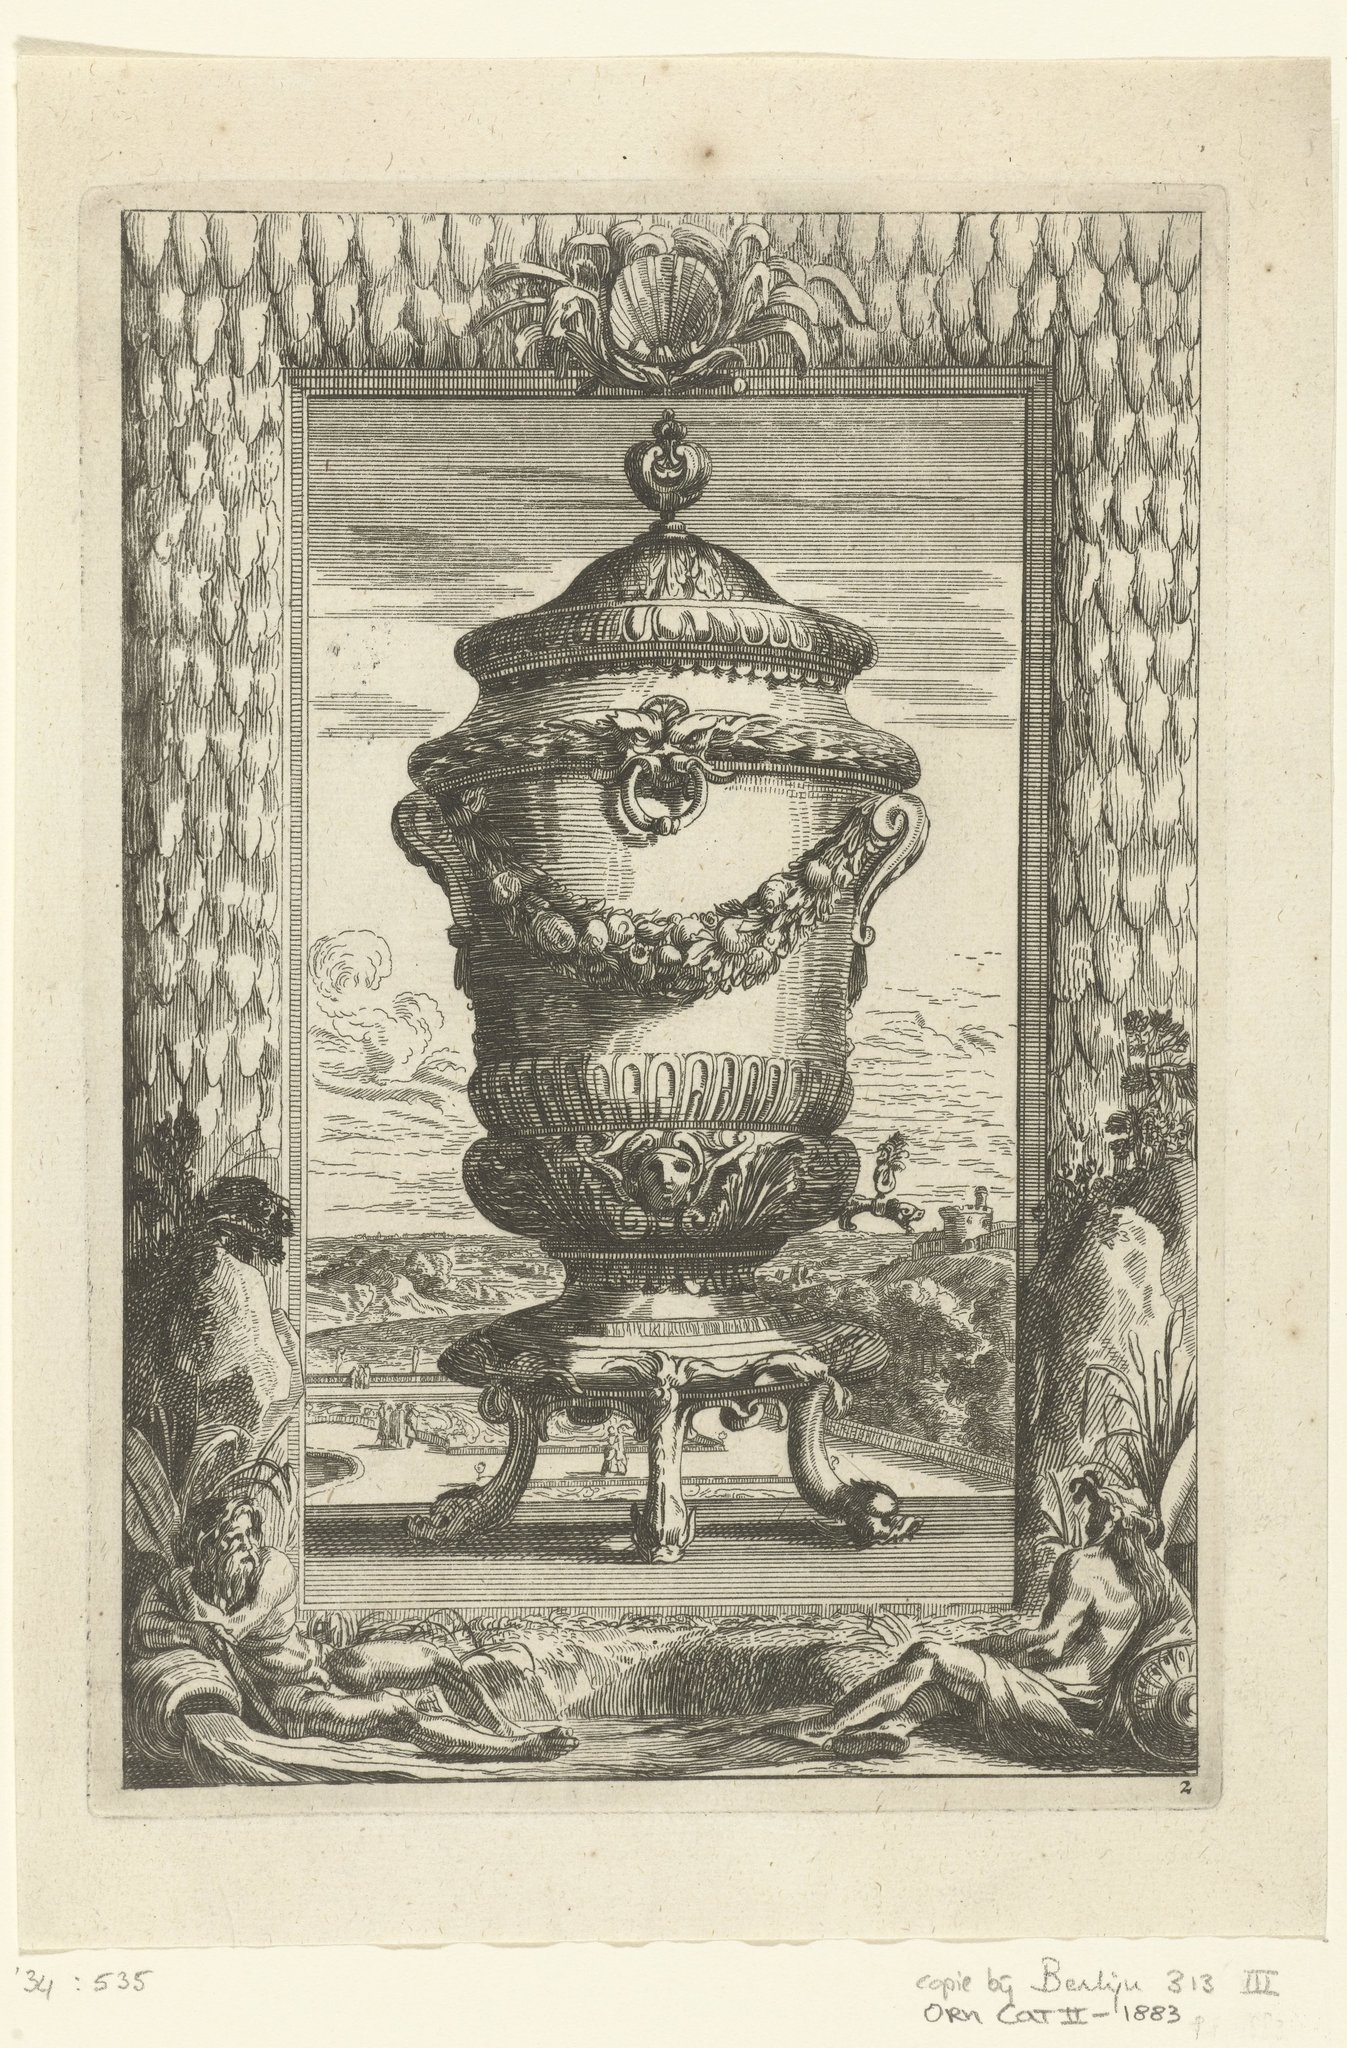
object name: print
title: Diverses Vases à l'Italienne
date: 1655-1678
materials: paper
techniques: etching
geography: netherlands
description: De fontein is afgebeeld met de kraan aan de rechterkant.